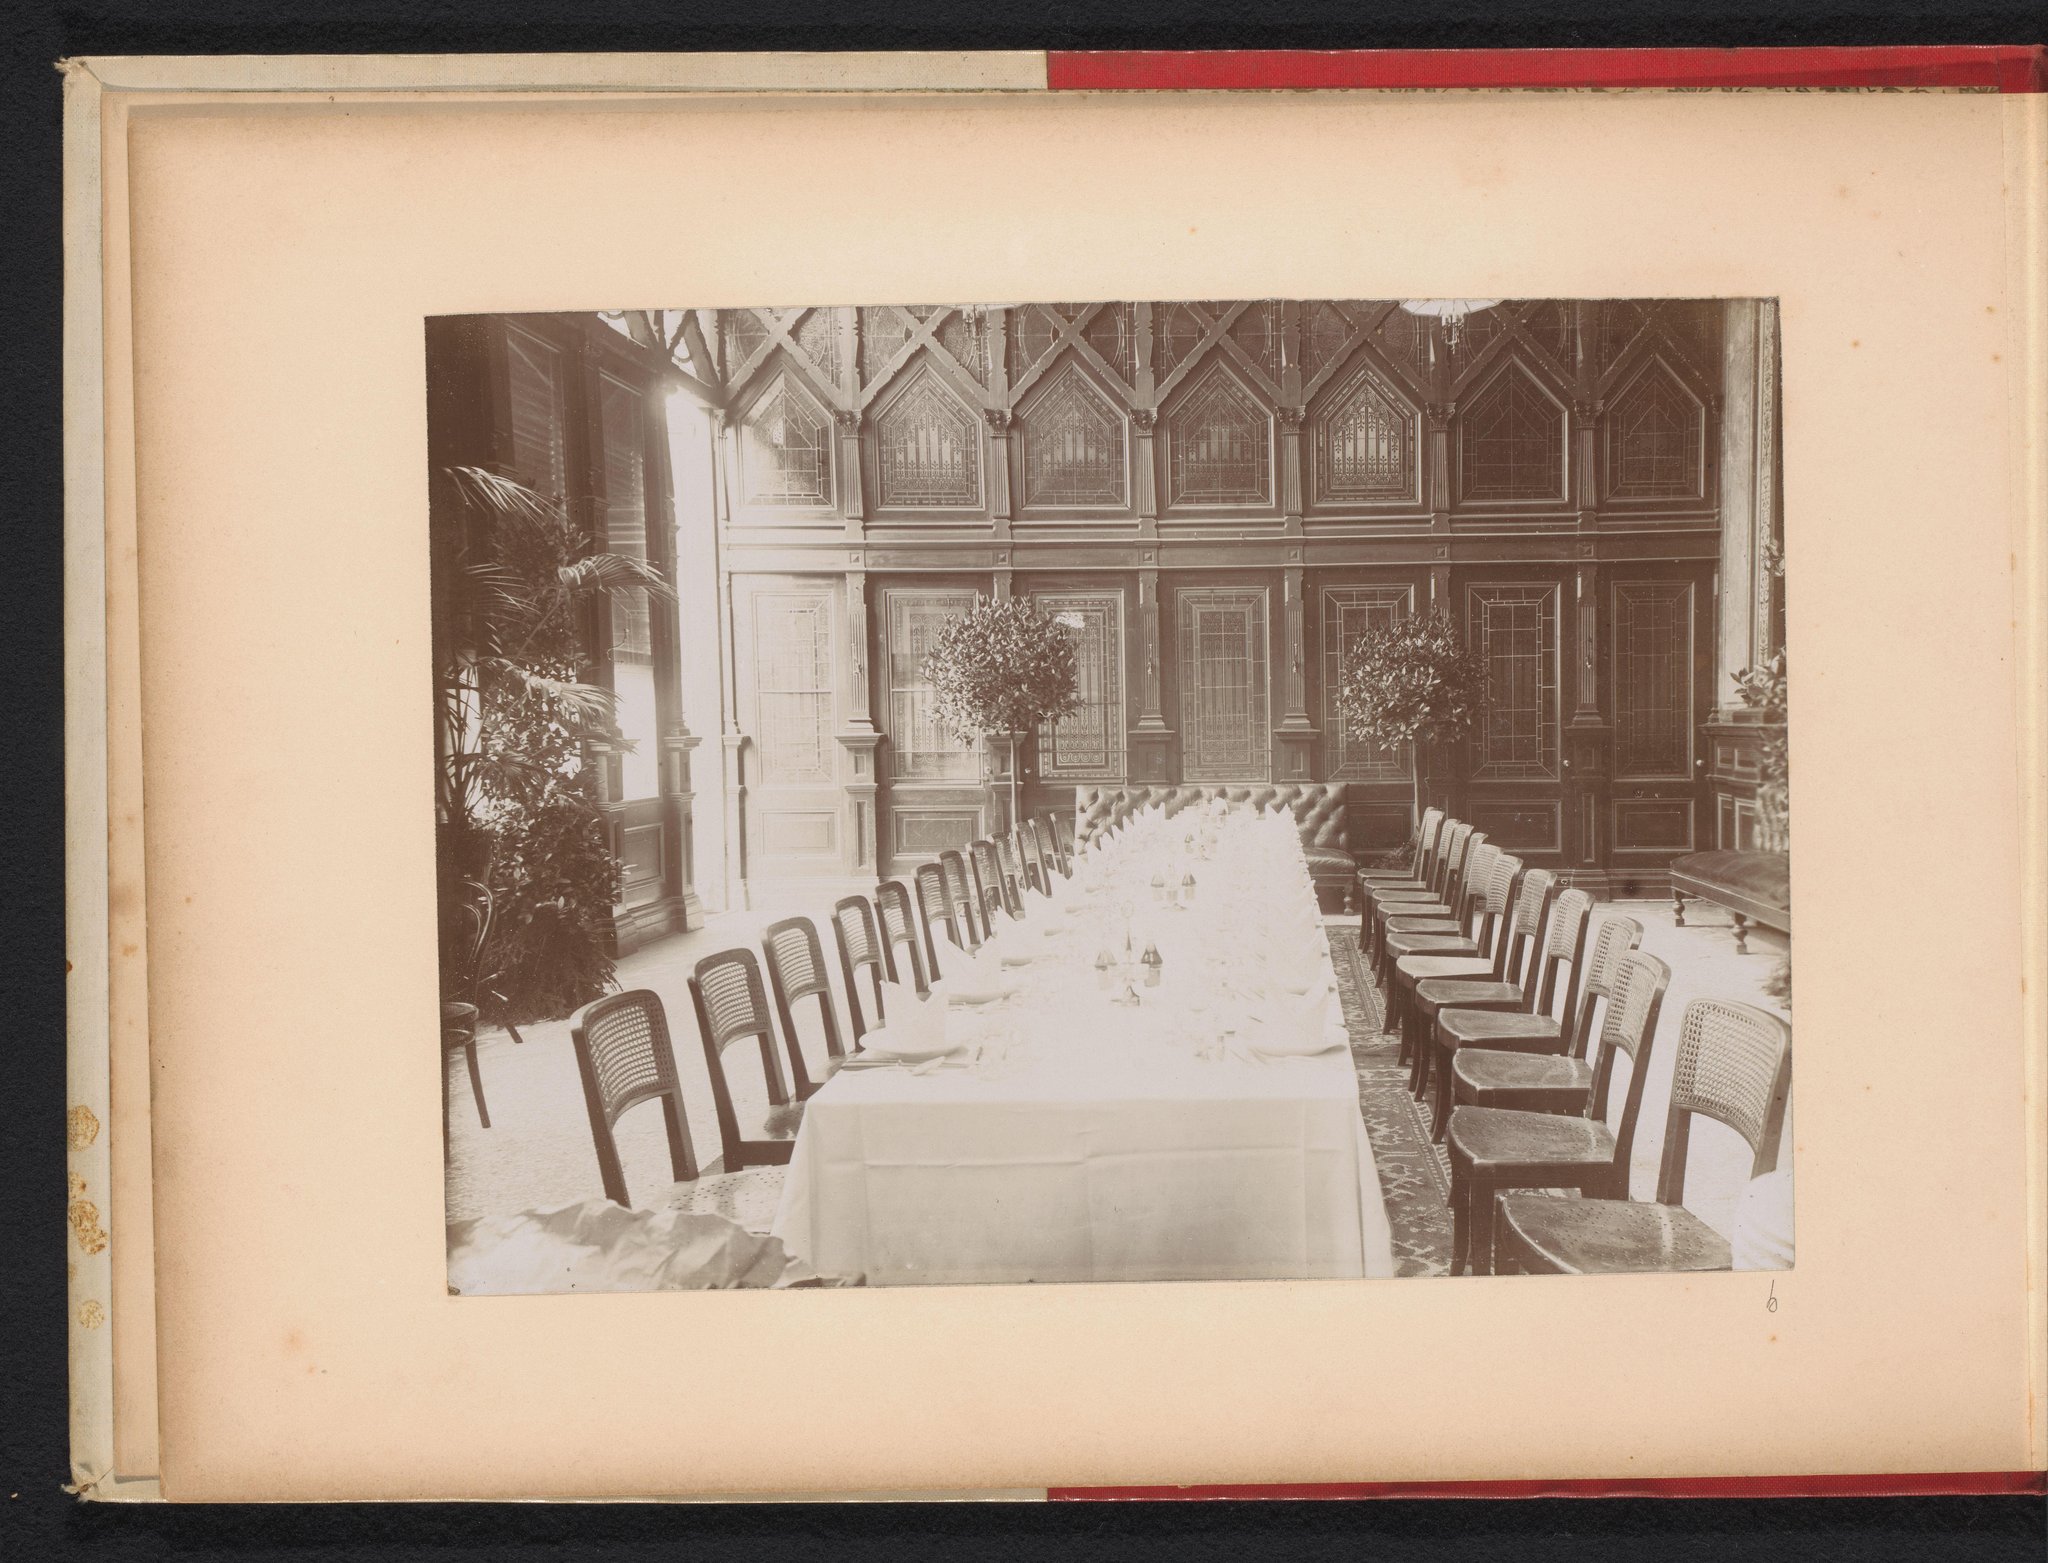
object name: photograph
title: Gedekte tafel in een eetzaal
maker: nicolaas schuitvlot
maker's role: fotograaf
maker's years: 1859-1947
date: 1806-1897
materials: cardboard, photographic support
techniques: collodion silver print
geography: amsterdam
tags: dining-room, laid table: table-ware, table-decoration, etc., amsterdam